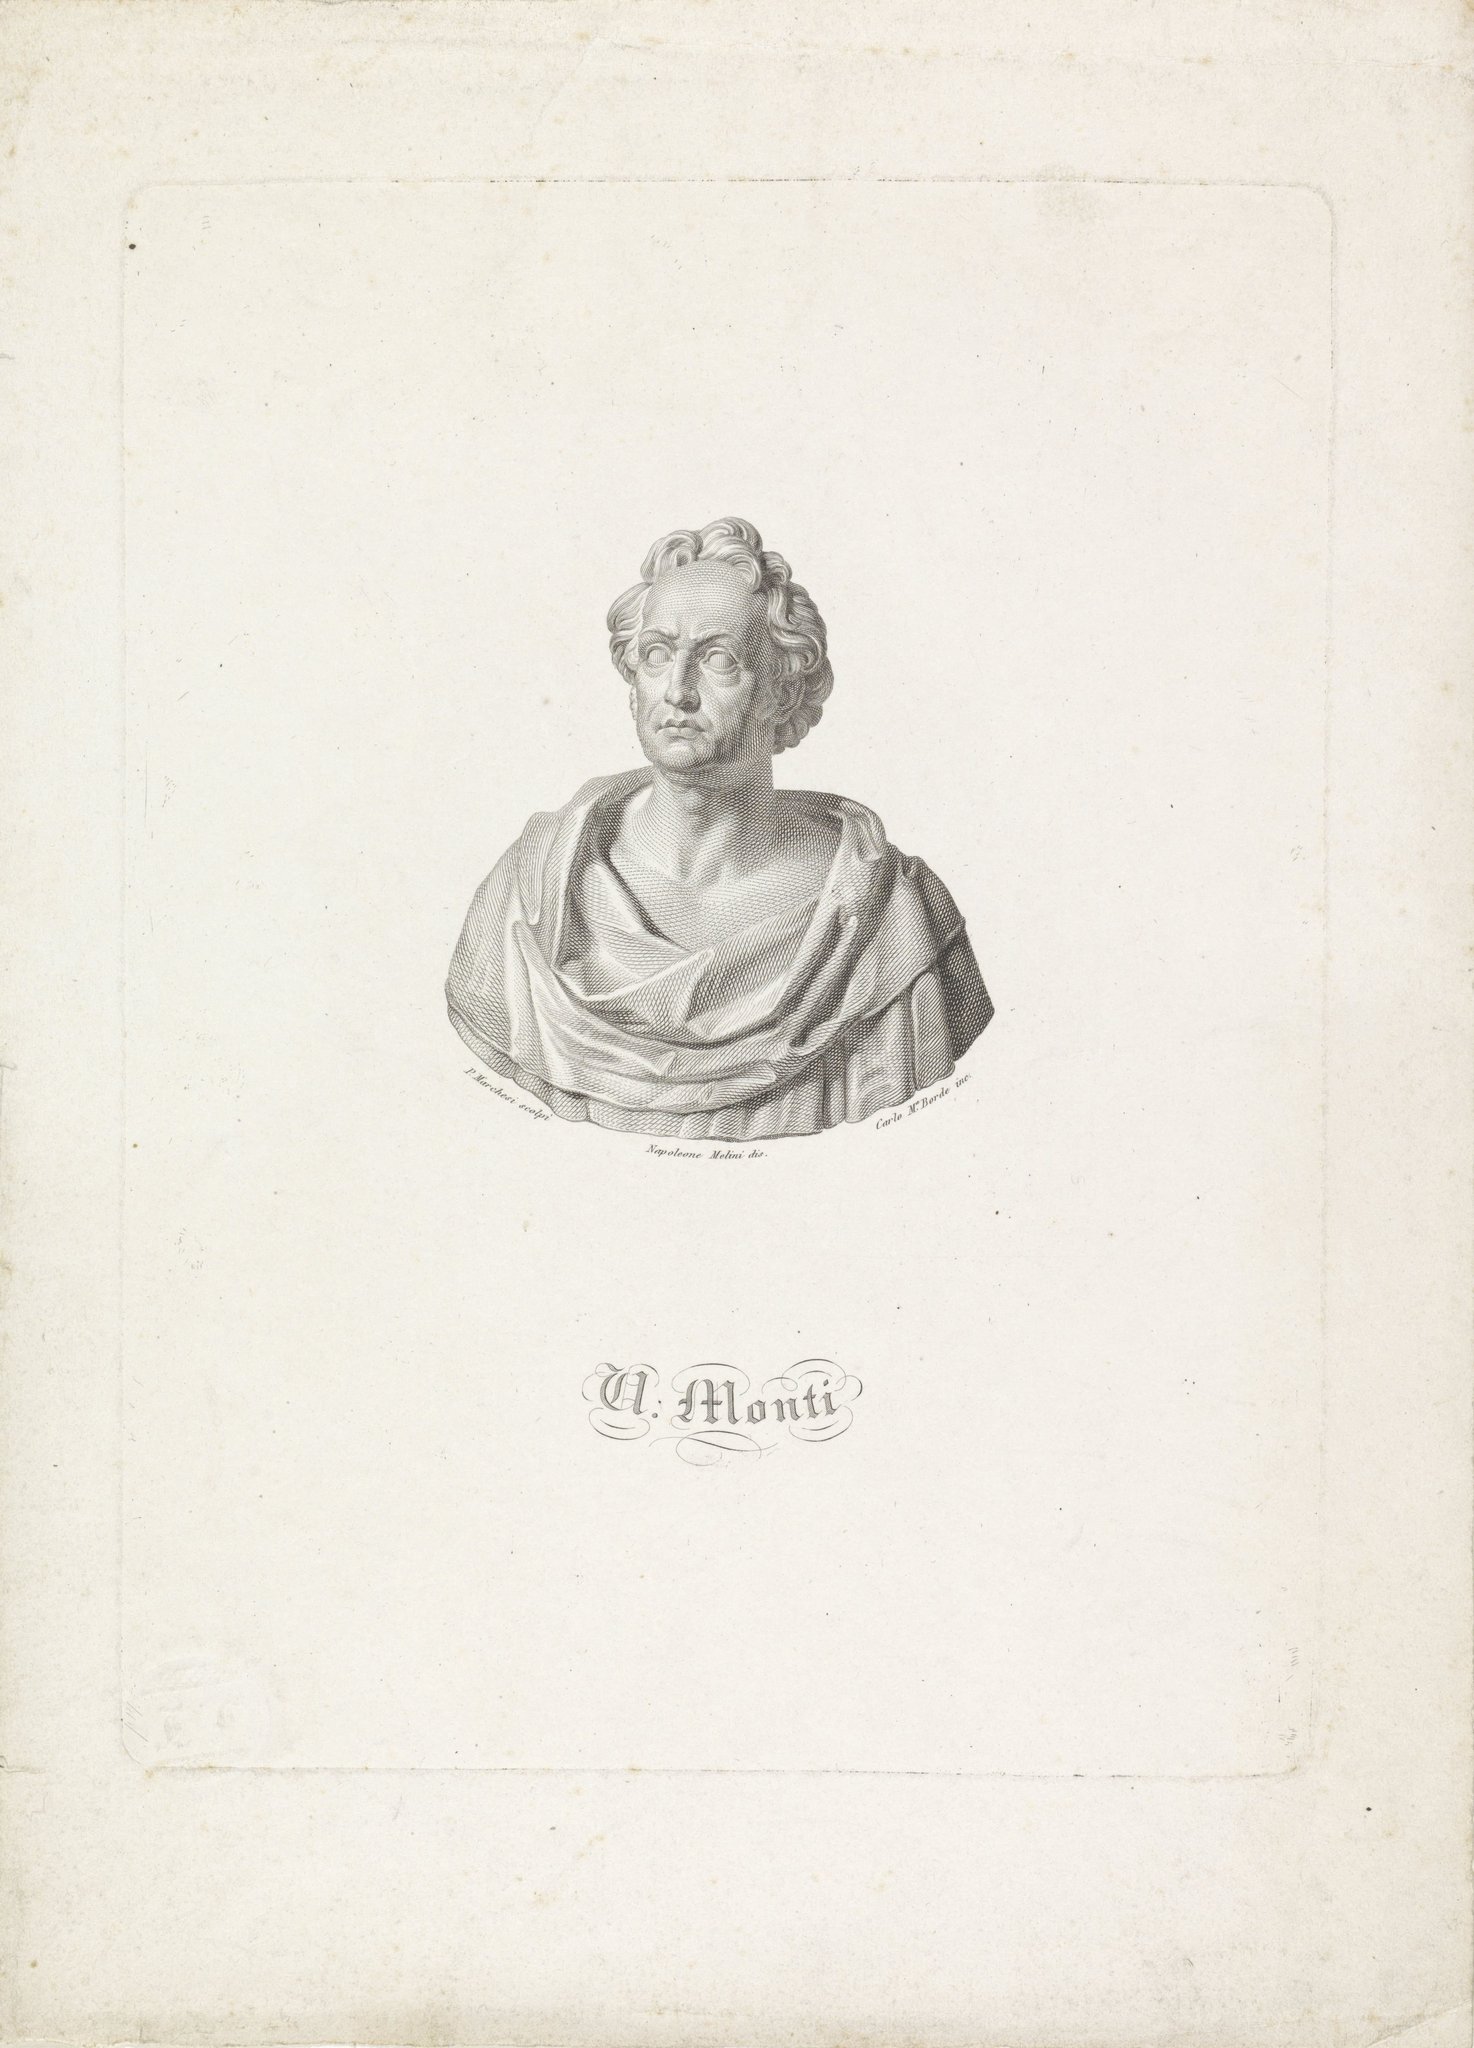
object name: print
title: Portret van U. Monti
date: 1800-1899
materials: paper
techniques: engraving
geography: italy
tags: historical persons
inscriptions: collector's mark: ‘LF’, collector's mark: Lugt 2228